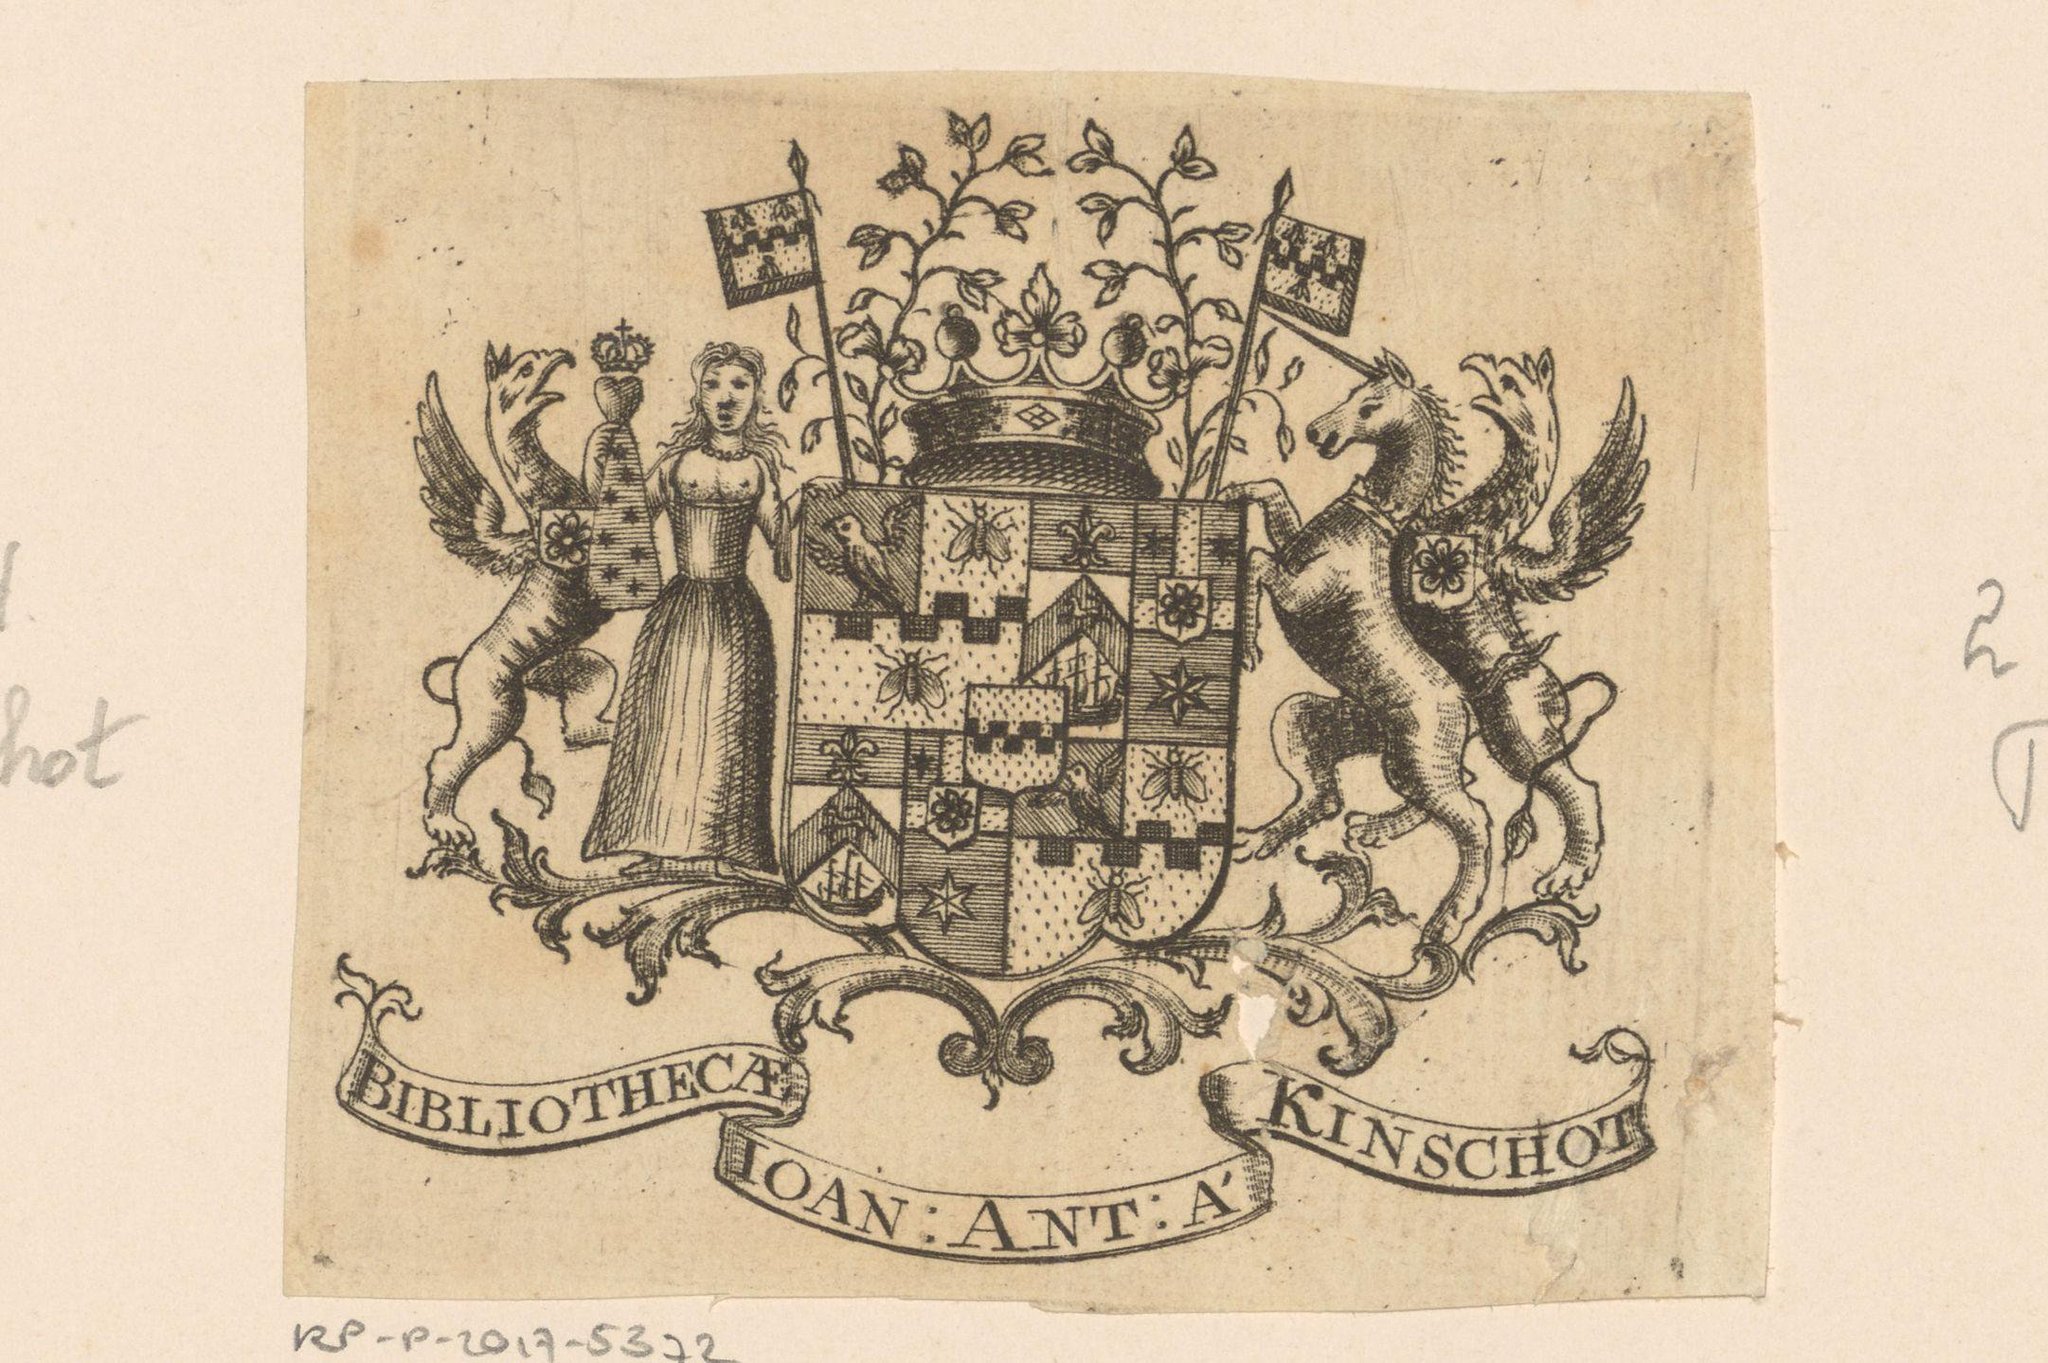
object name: bookplate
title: Ex libris van Johan Anthonie van Kinschot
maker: Anonymous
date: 1718-1766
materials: paper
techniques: etching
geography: netherlands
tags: griffin (lion/eagle); 'griffo' (ripa), unicorn, armorial bearing, heraldry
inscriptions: inscription: ‘1 en 4 kinschot / 2 en 3 Tromp / Vrouw en eenhoorn v. Kinschot / Griffioenen Tromp / Een familie Van Kinschot voerende / wapen als 1 en 4 werd 25 januari / 1848 ingelijfd in den Nederl. Adel / Vergel. Rietstap, 941 Tr / 1093 v.K.’